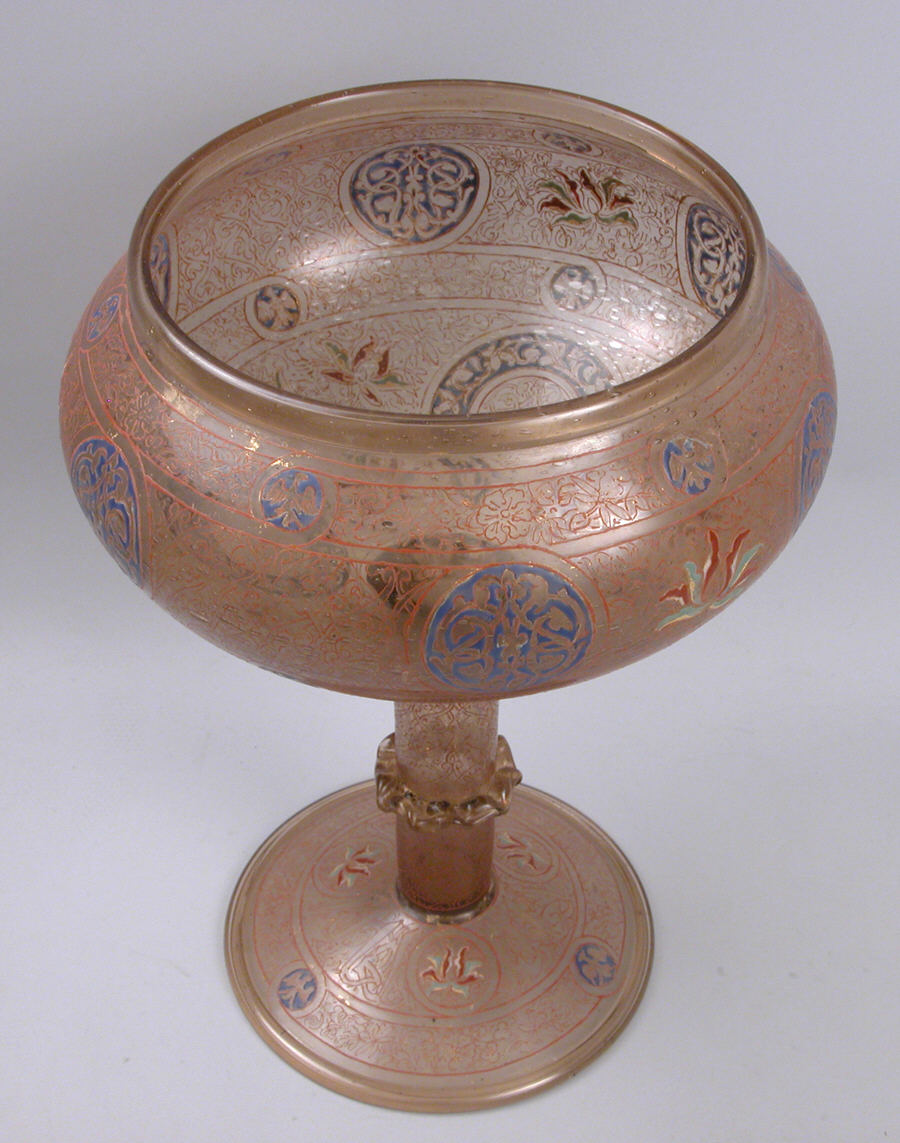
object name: footed bowl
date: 1326-1350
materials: glass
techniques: enamel, glassblowing, gilding, tooling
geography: egypt or syria